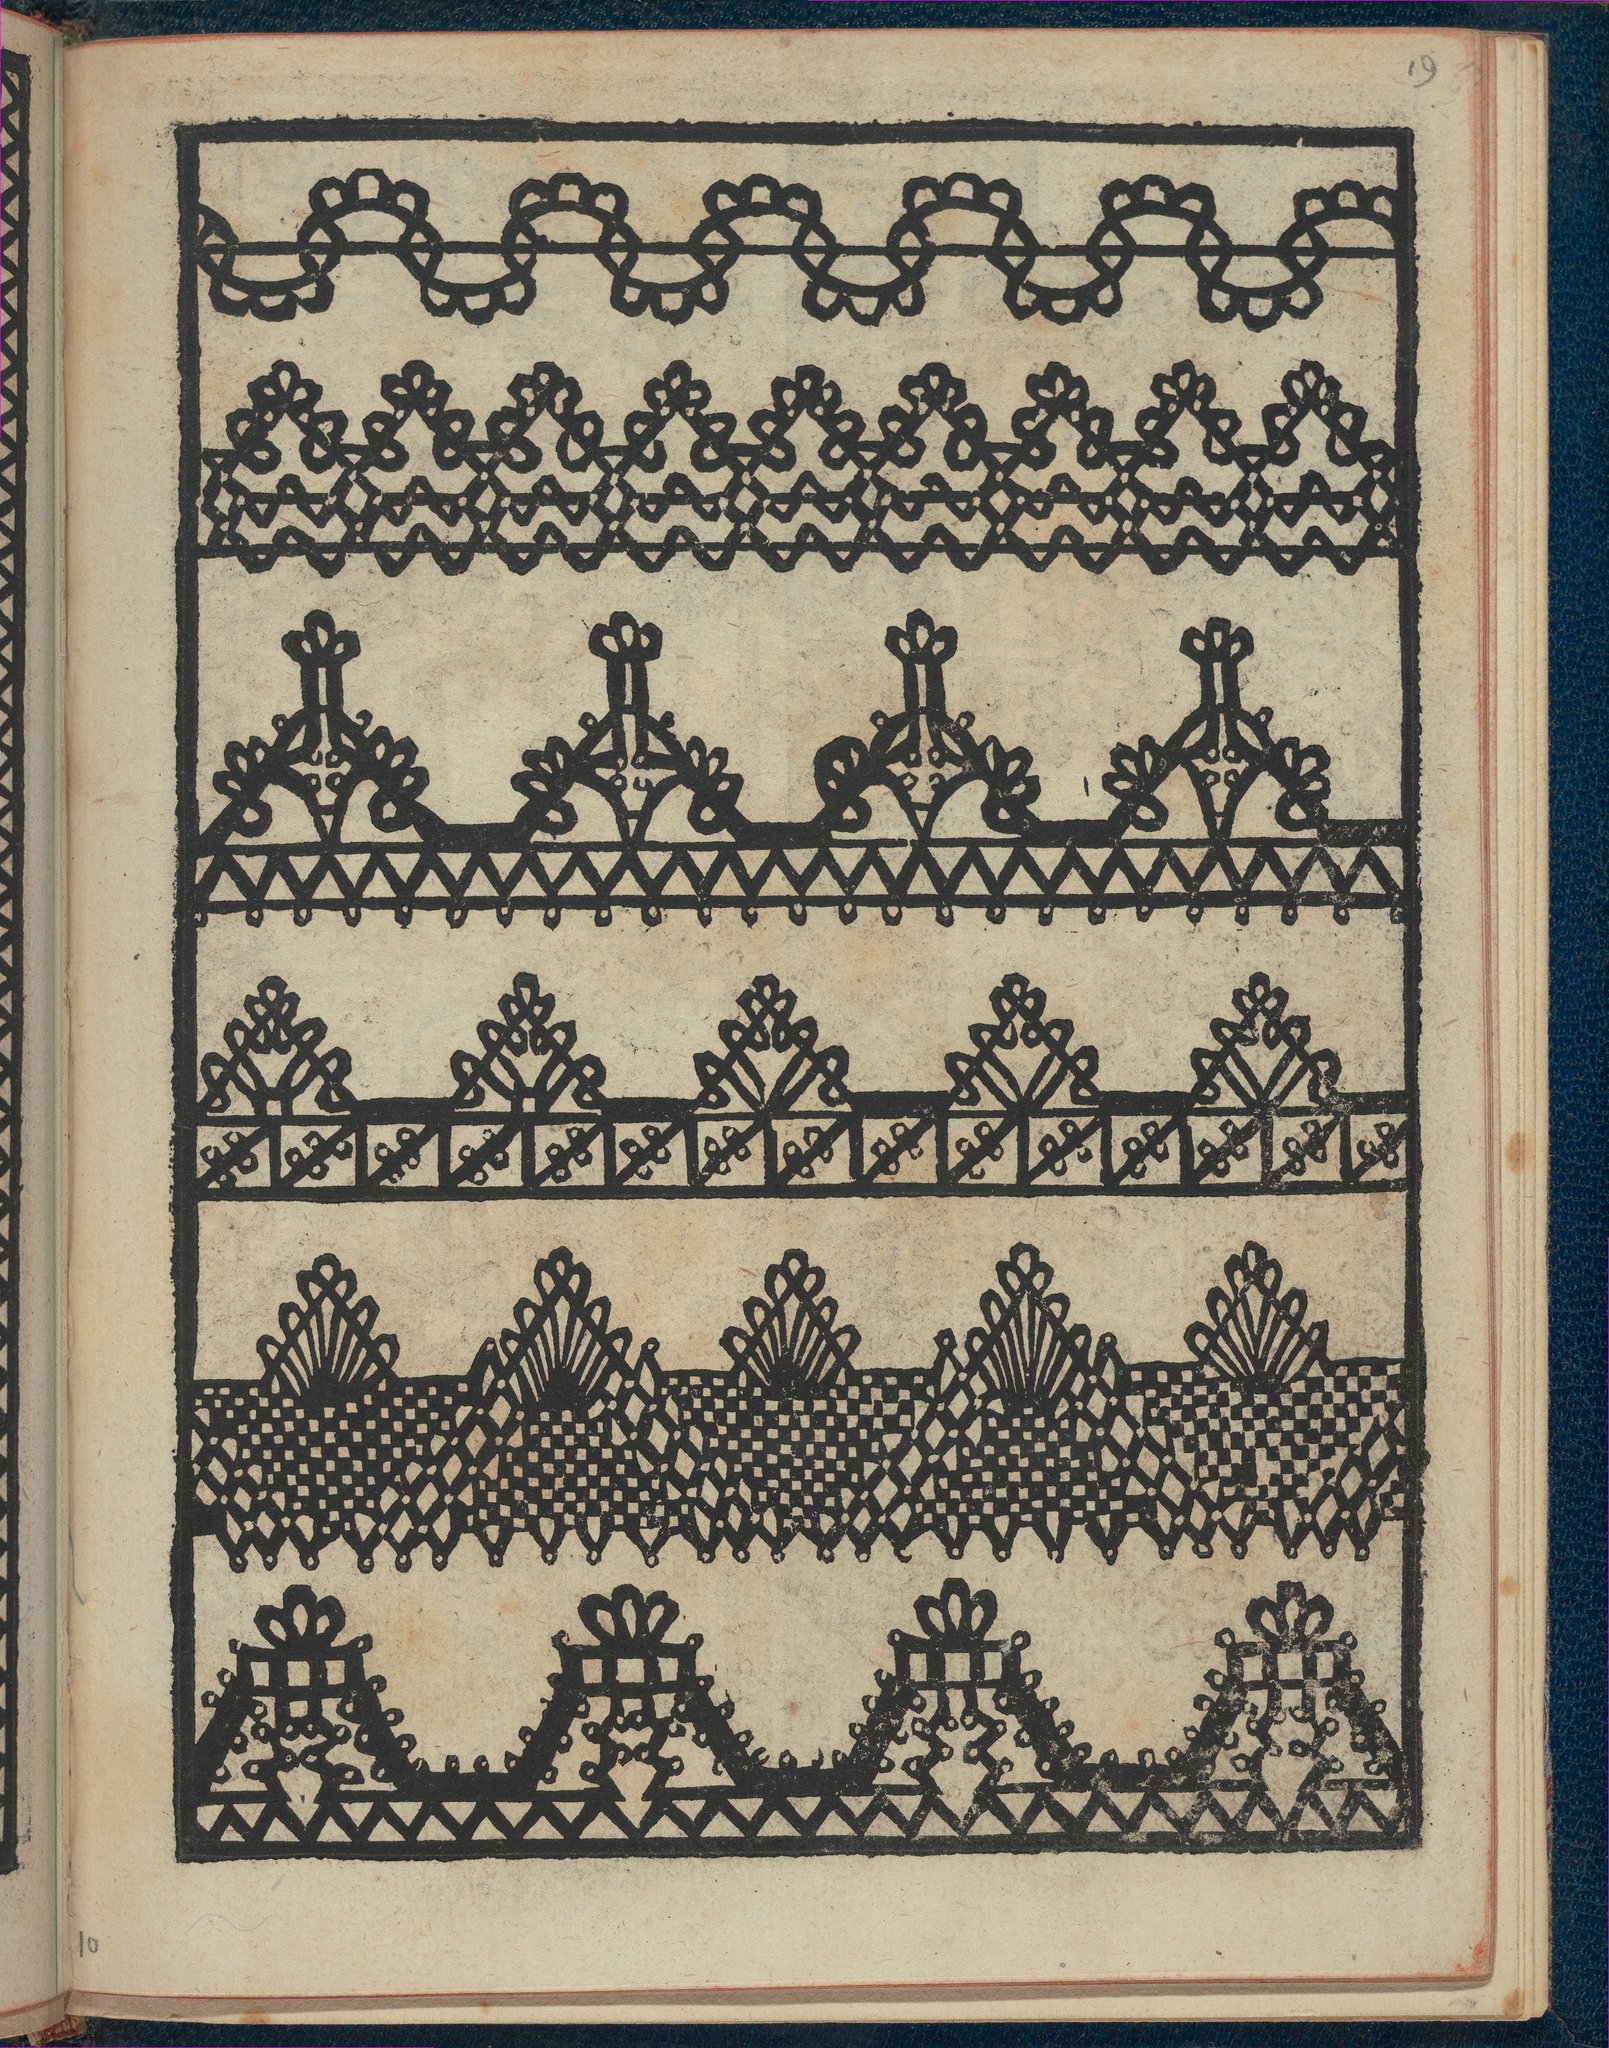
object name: book print ornament architecture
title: Le Pompe: Opera Nova, page 10 (recto)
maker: giovanni battista & marchio sessa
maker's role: publisher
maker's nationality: italian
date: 1557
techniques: woodcut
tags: ornament